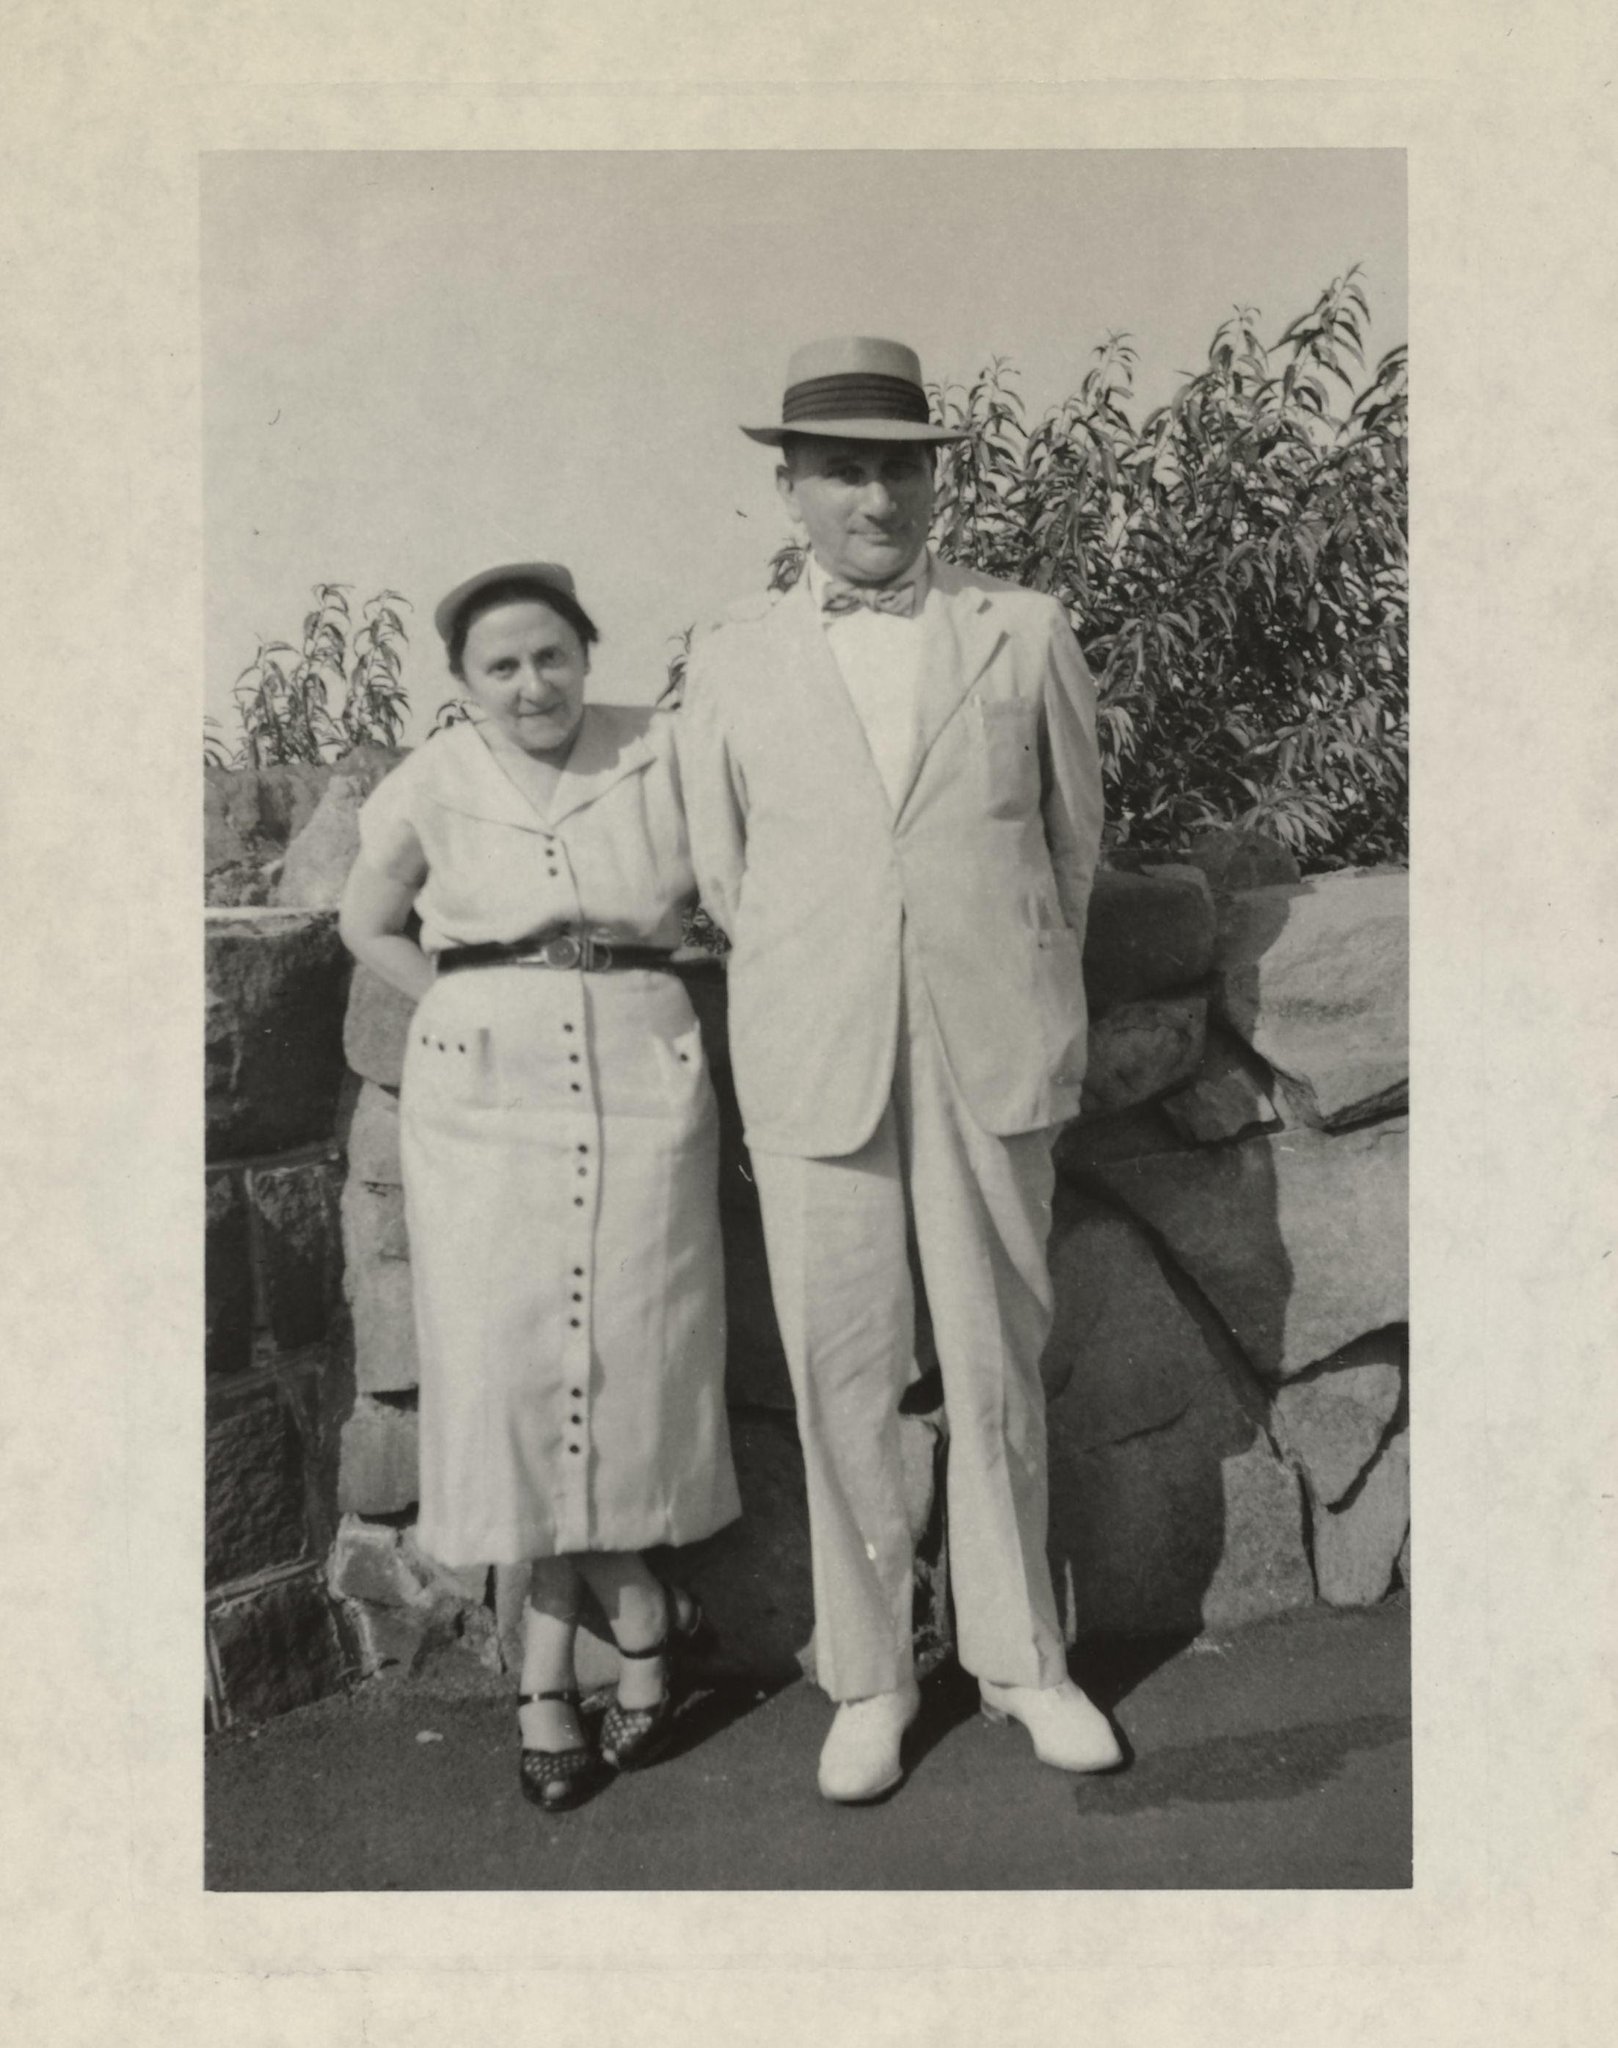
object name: photograph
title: Tante Rosel en oom Julius staande voor een stenen muur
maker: Anonymous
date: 1907-1953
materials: photographic support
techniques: gelatin silver print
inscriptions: inscription: ‘Deine Rosel Tante u. Onkel Julius Juli 1953’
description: Tante Rosel (links) en oom Julius (rechts), staande voor een stenen muur op een donkere ondergrond, met struiken achter de stenen muur.